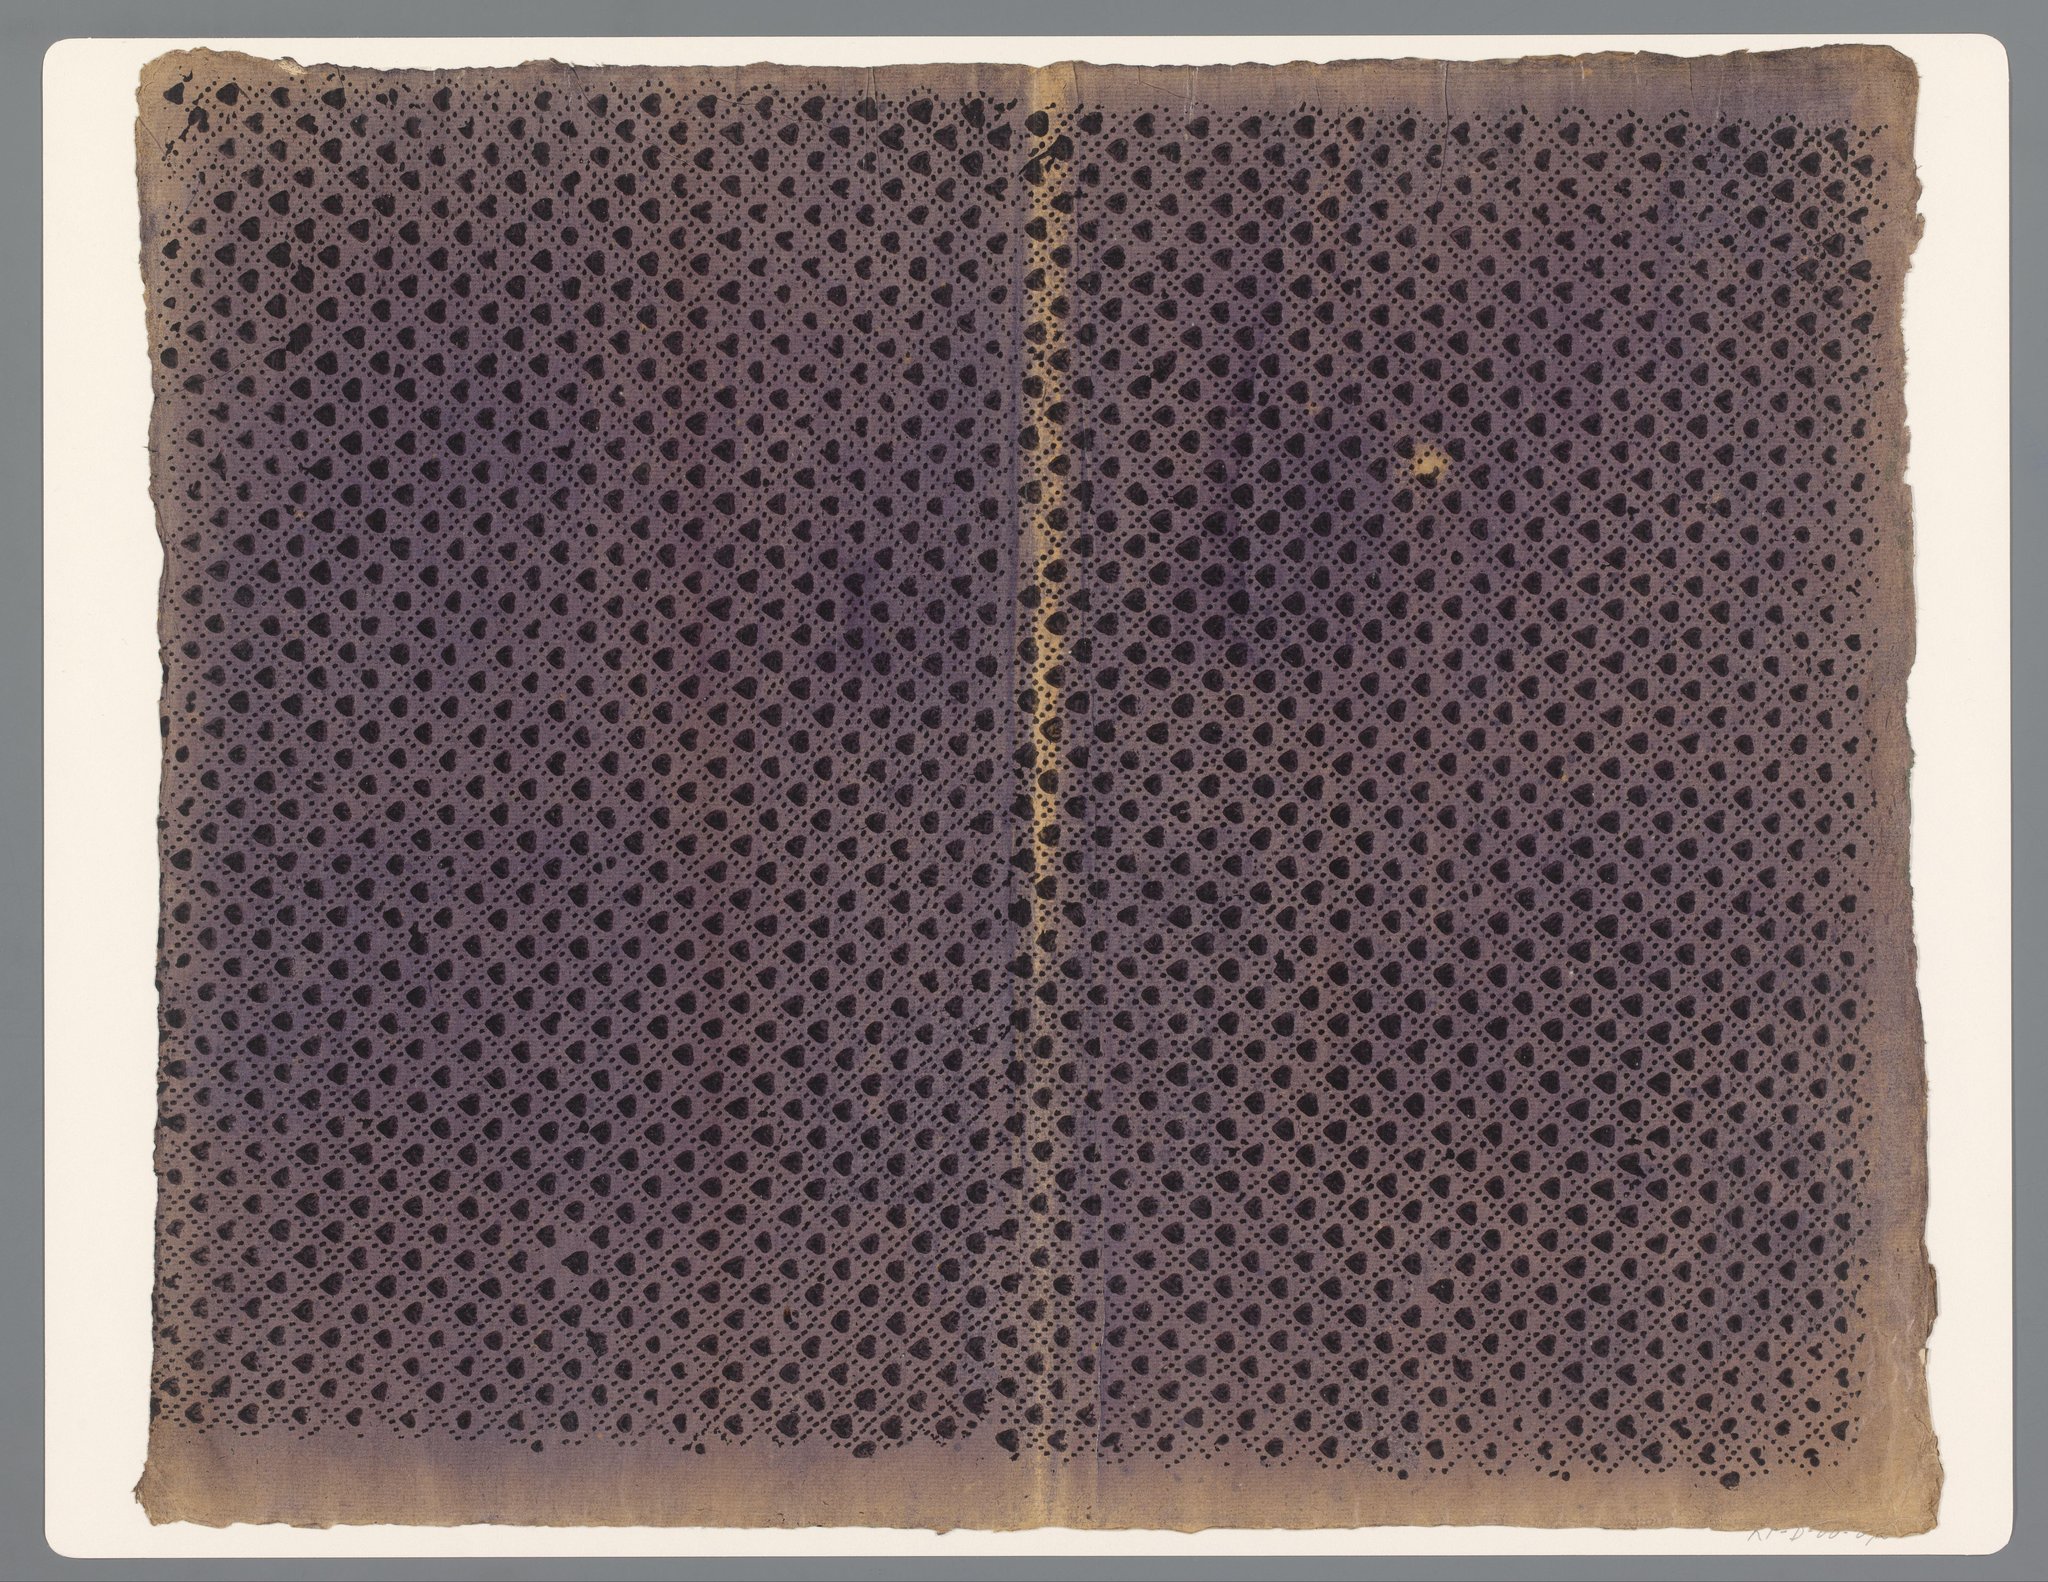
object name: printed paper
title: Blad met ruitenpatroon met hartjes als veldvulling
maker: Anonymous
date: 1750-1900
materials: lacquer, paper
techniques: printing block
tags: ornament derived from objects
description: Blad met ruitenpatroon met harten als veldvulling. Mogelijk gebruikt als omslag.